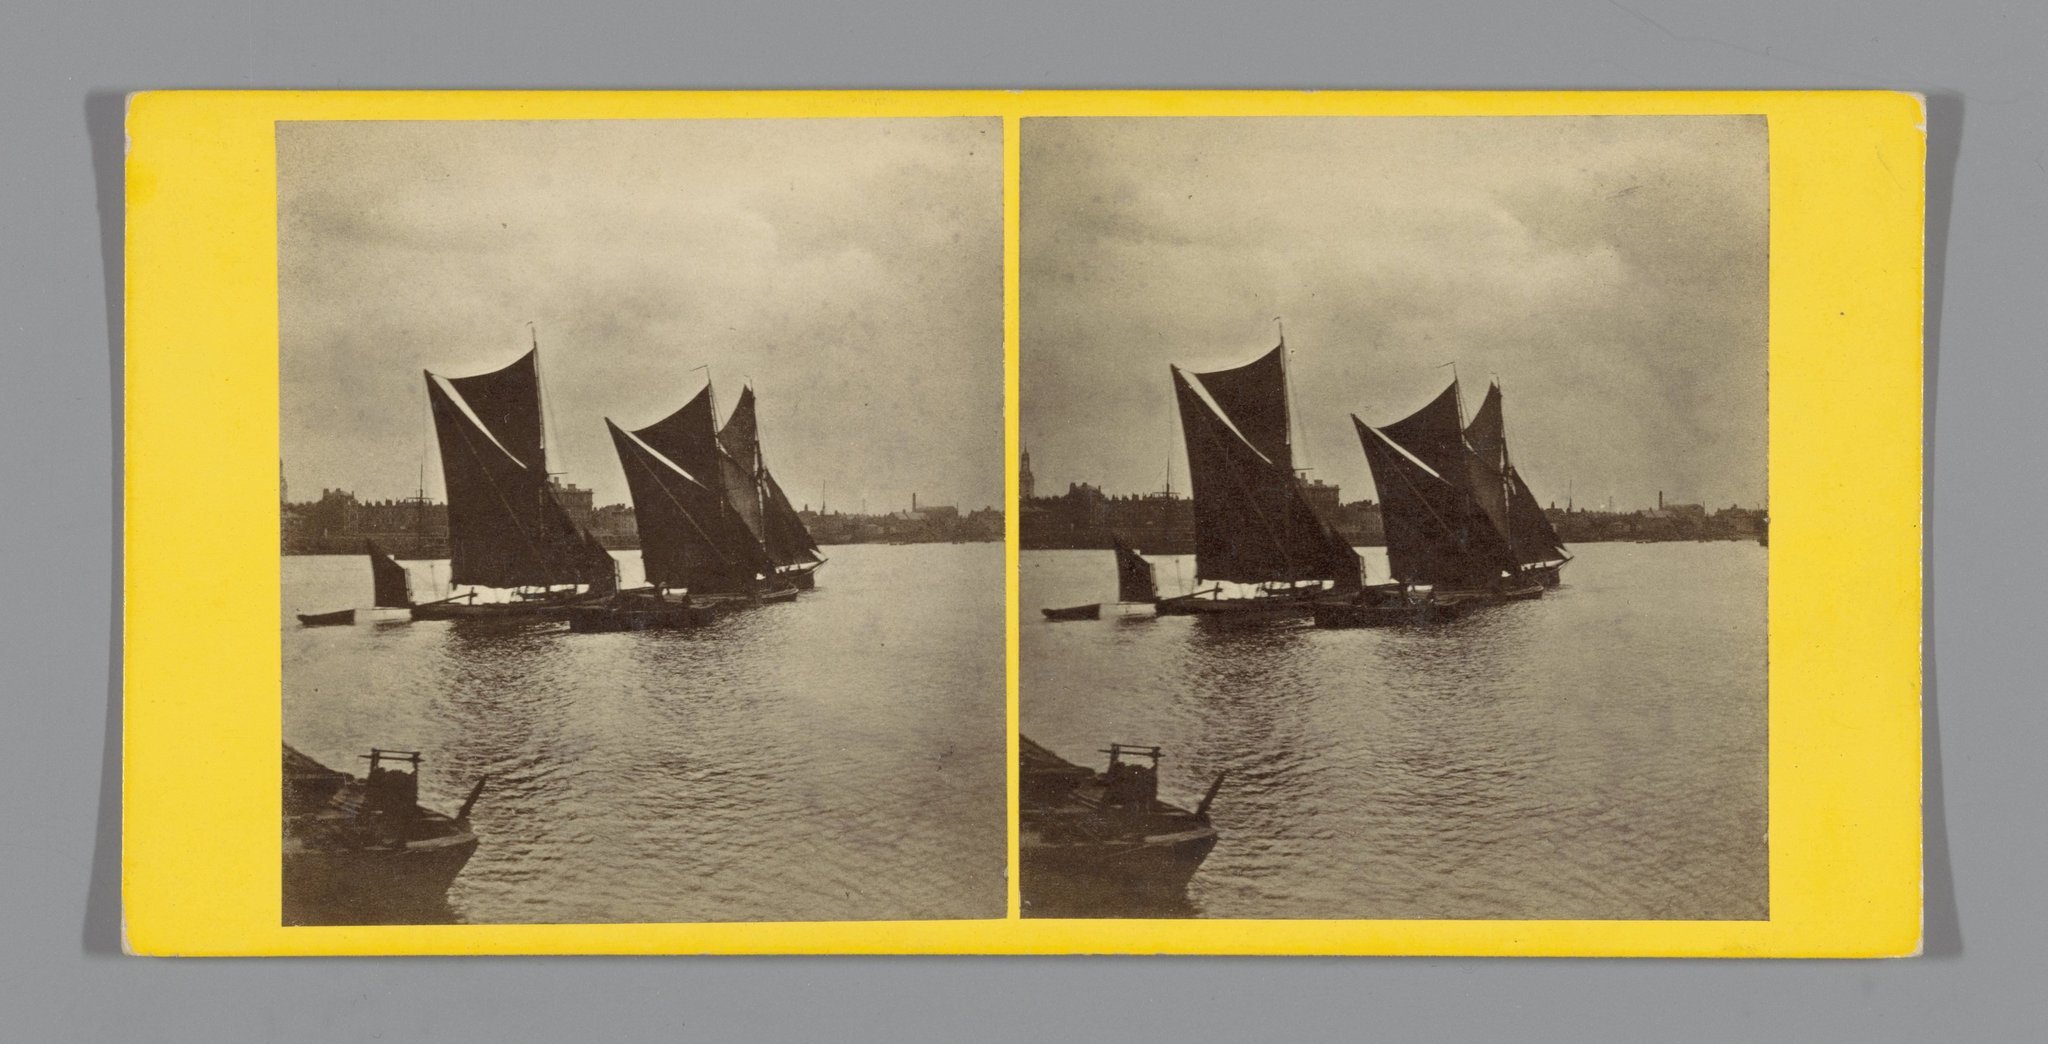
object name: stereograph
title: Schepen op de Theems bij Greenwich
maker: george washington wilson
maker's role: publisher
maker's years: 1823-1893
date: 1850-1880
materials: cardboard, photographic support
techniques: albumen print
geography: thames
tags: river, ships (in general), thames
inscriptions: inscription: ‘Juni 1886.’, number: ‘No. 328.’, name: ‘G. W. Wilson, Photographer, Aberdeen.’